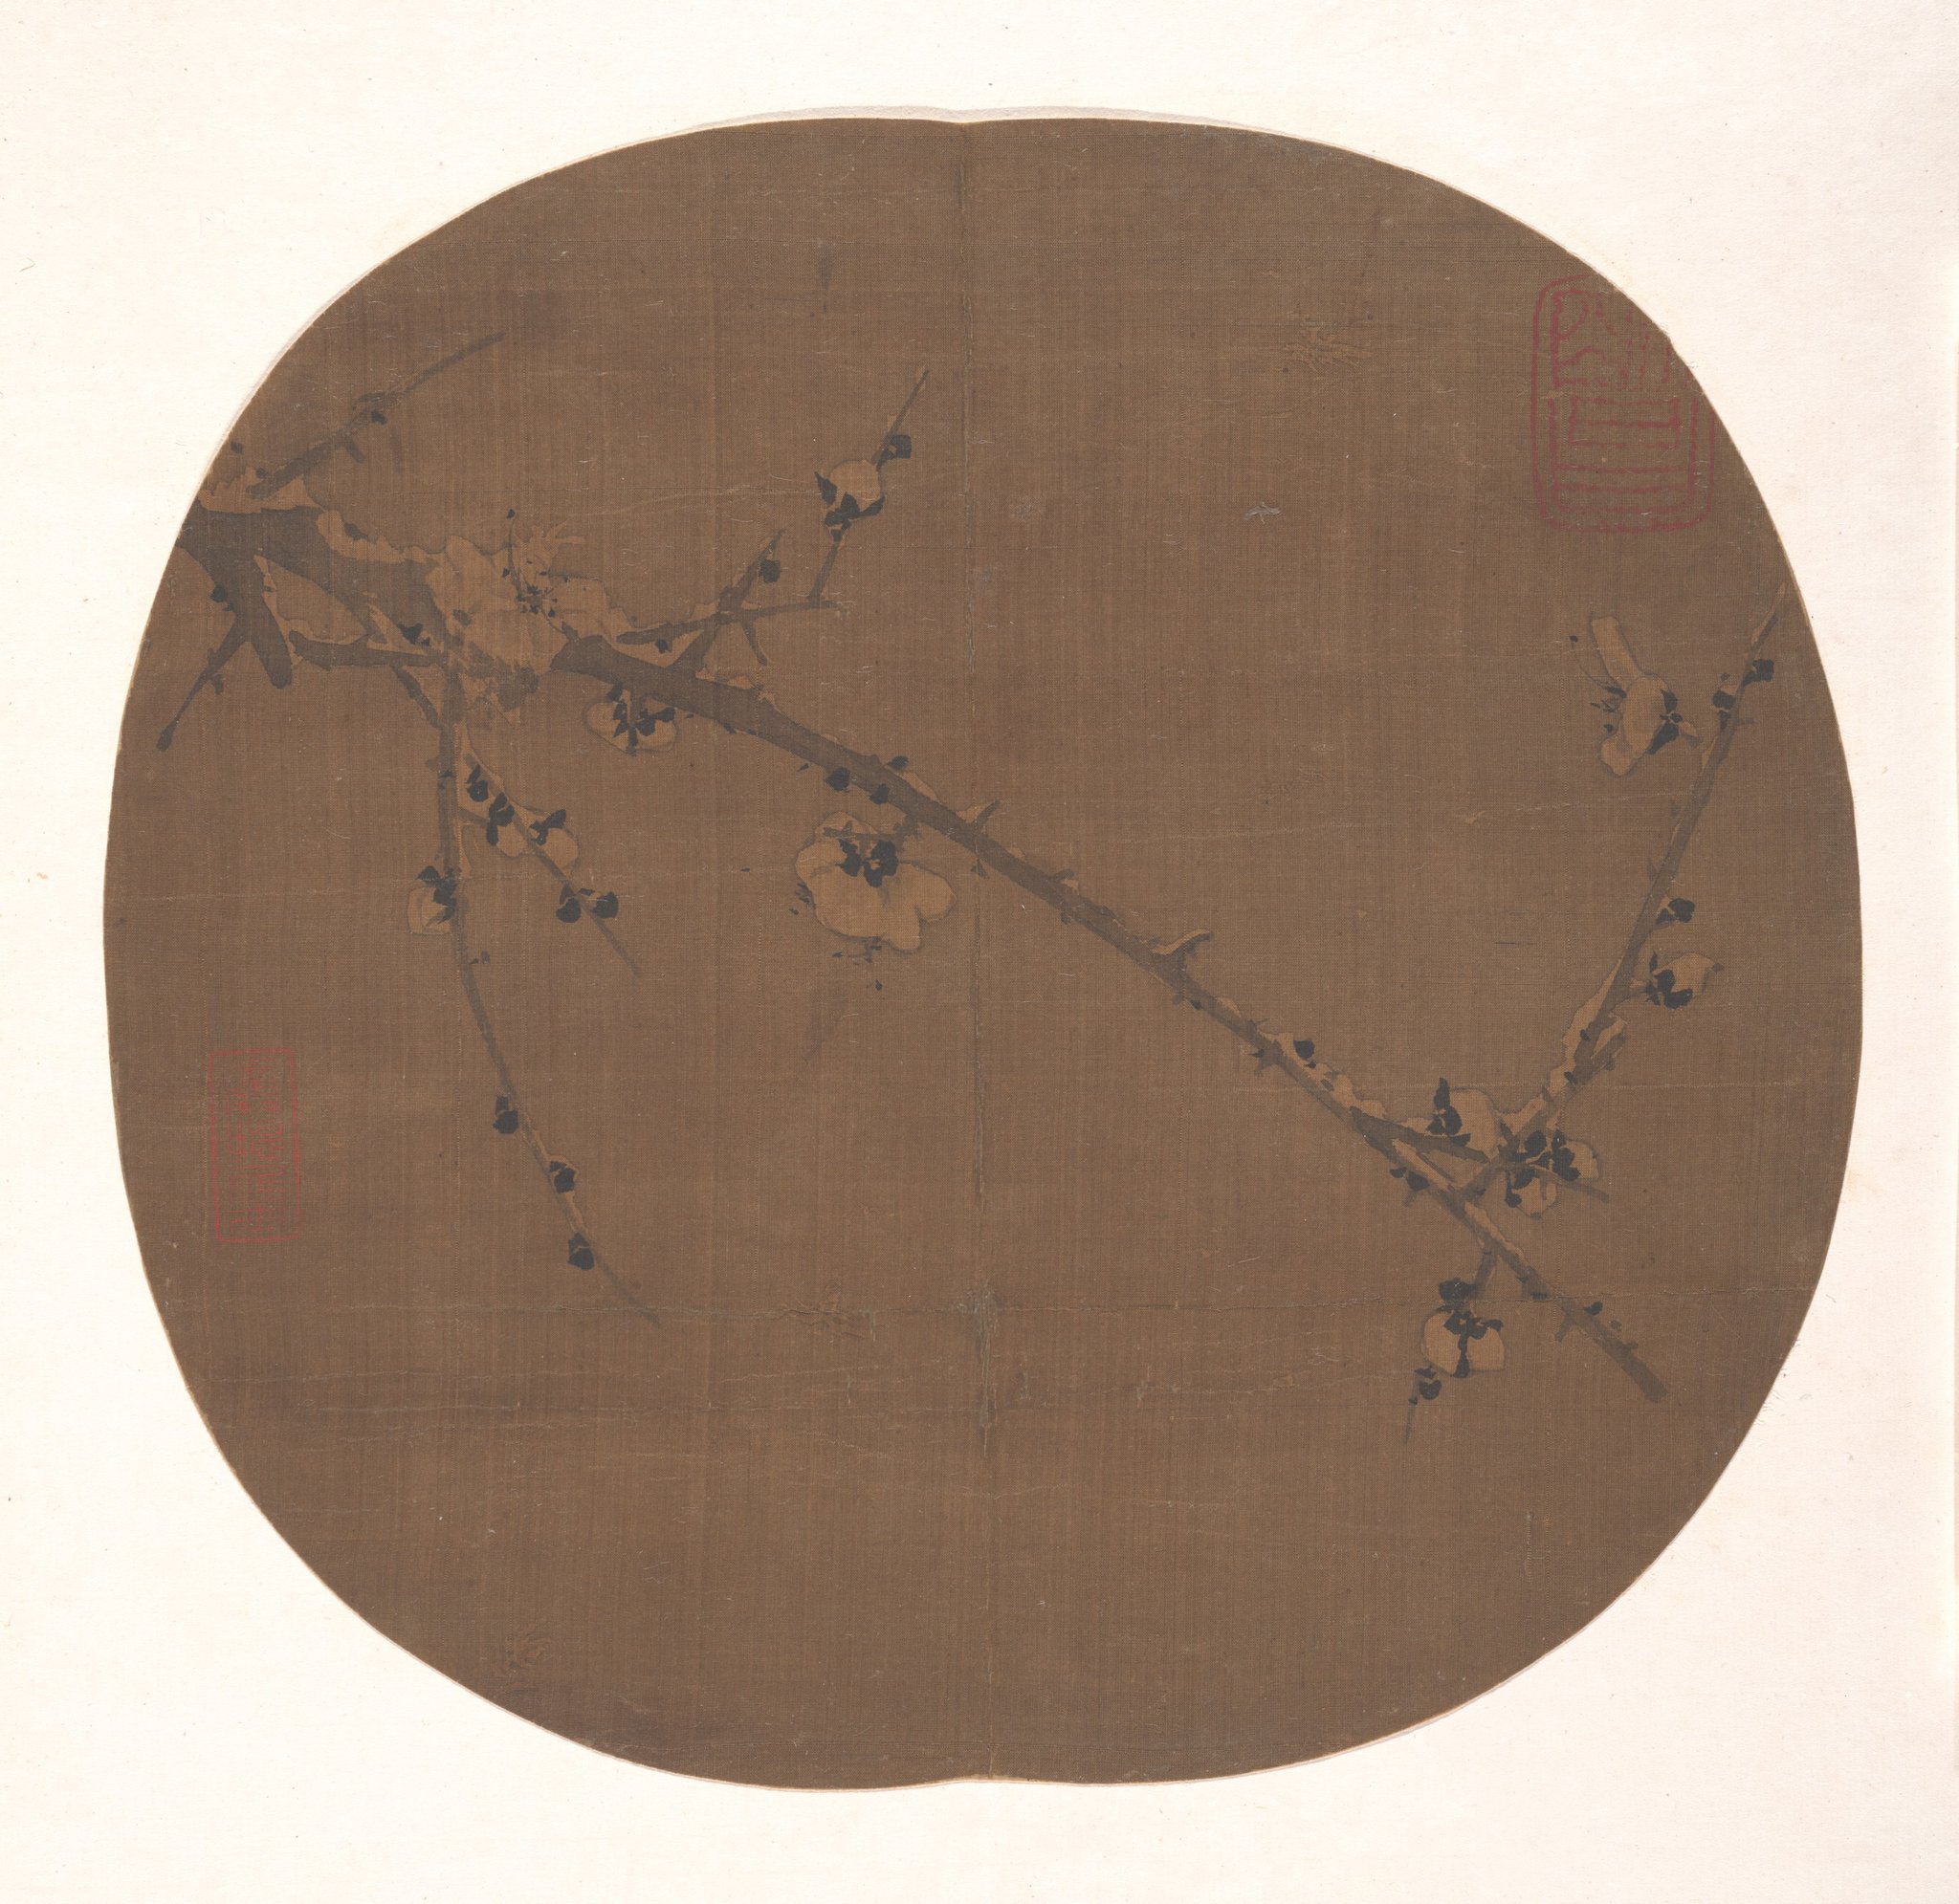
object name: album leaf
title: Snow Plum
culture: chinese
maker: unidentified artist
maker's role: artist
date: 960-1279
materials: ink, silk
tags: flowers